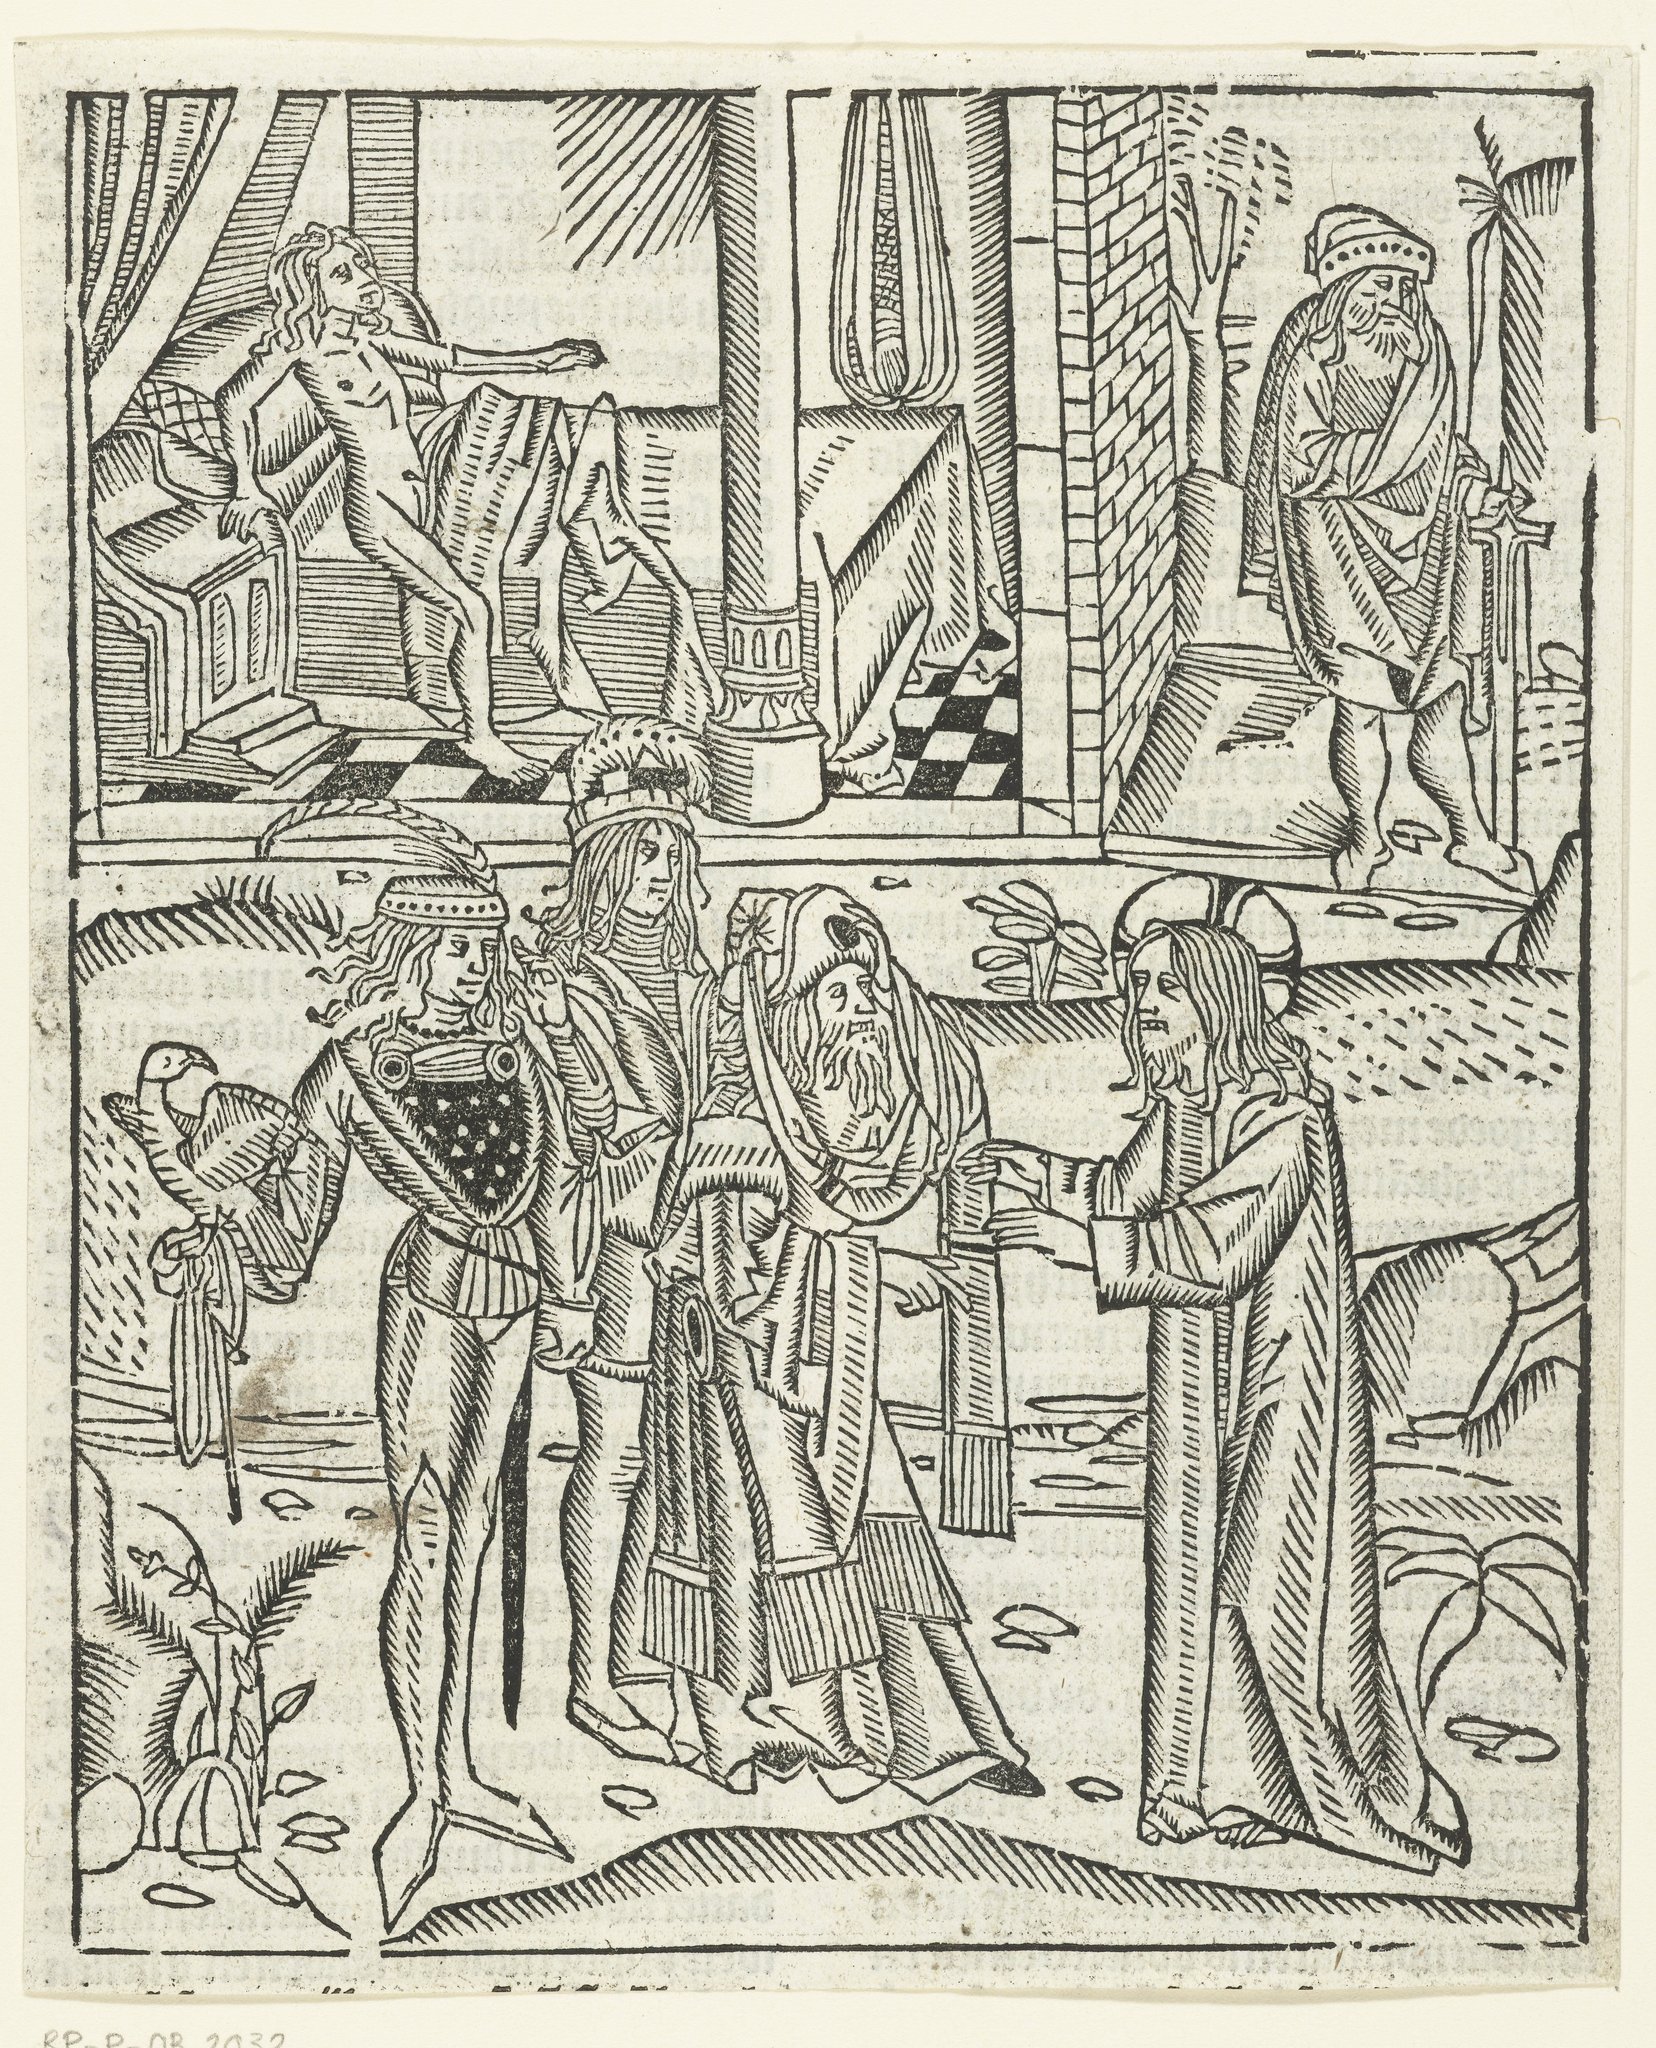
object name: book illustration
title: Christus geneest de knecht van de centurio van Kafarnaüm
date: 1480-1500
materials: paper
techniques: woodcut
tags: the servant (or son) of the centurion of capernaum is healed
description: Eén blad van 113 uit Ludolphus de Saxonia, "Dit es dleué ons liefs heeren ihesu christi". Anonieme Nederlandse vertaling. Uitgegeven door Henrick Eckert van Homberch te Antwerpen in 1503. Botke, K. Deze 113 houtsneden, die meestal reeds in vroege Nederlandse boeken gebruikt zijn, worden toegeschreven aan de tweede Meester van Delft, de Meester van de Delbecq-Schreiber-passie en de Meester van de Virgo inter Virgines. In Conway (1884) en in "De gulden passer"(1951) zijn ook eerdere versies opgenomen. Botke, K.